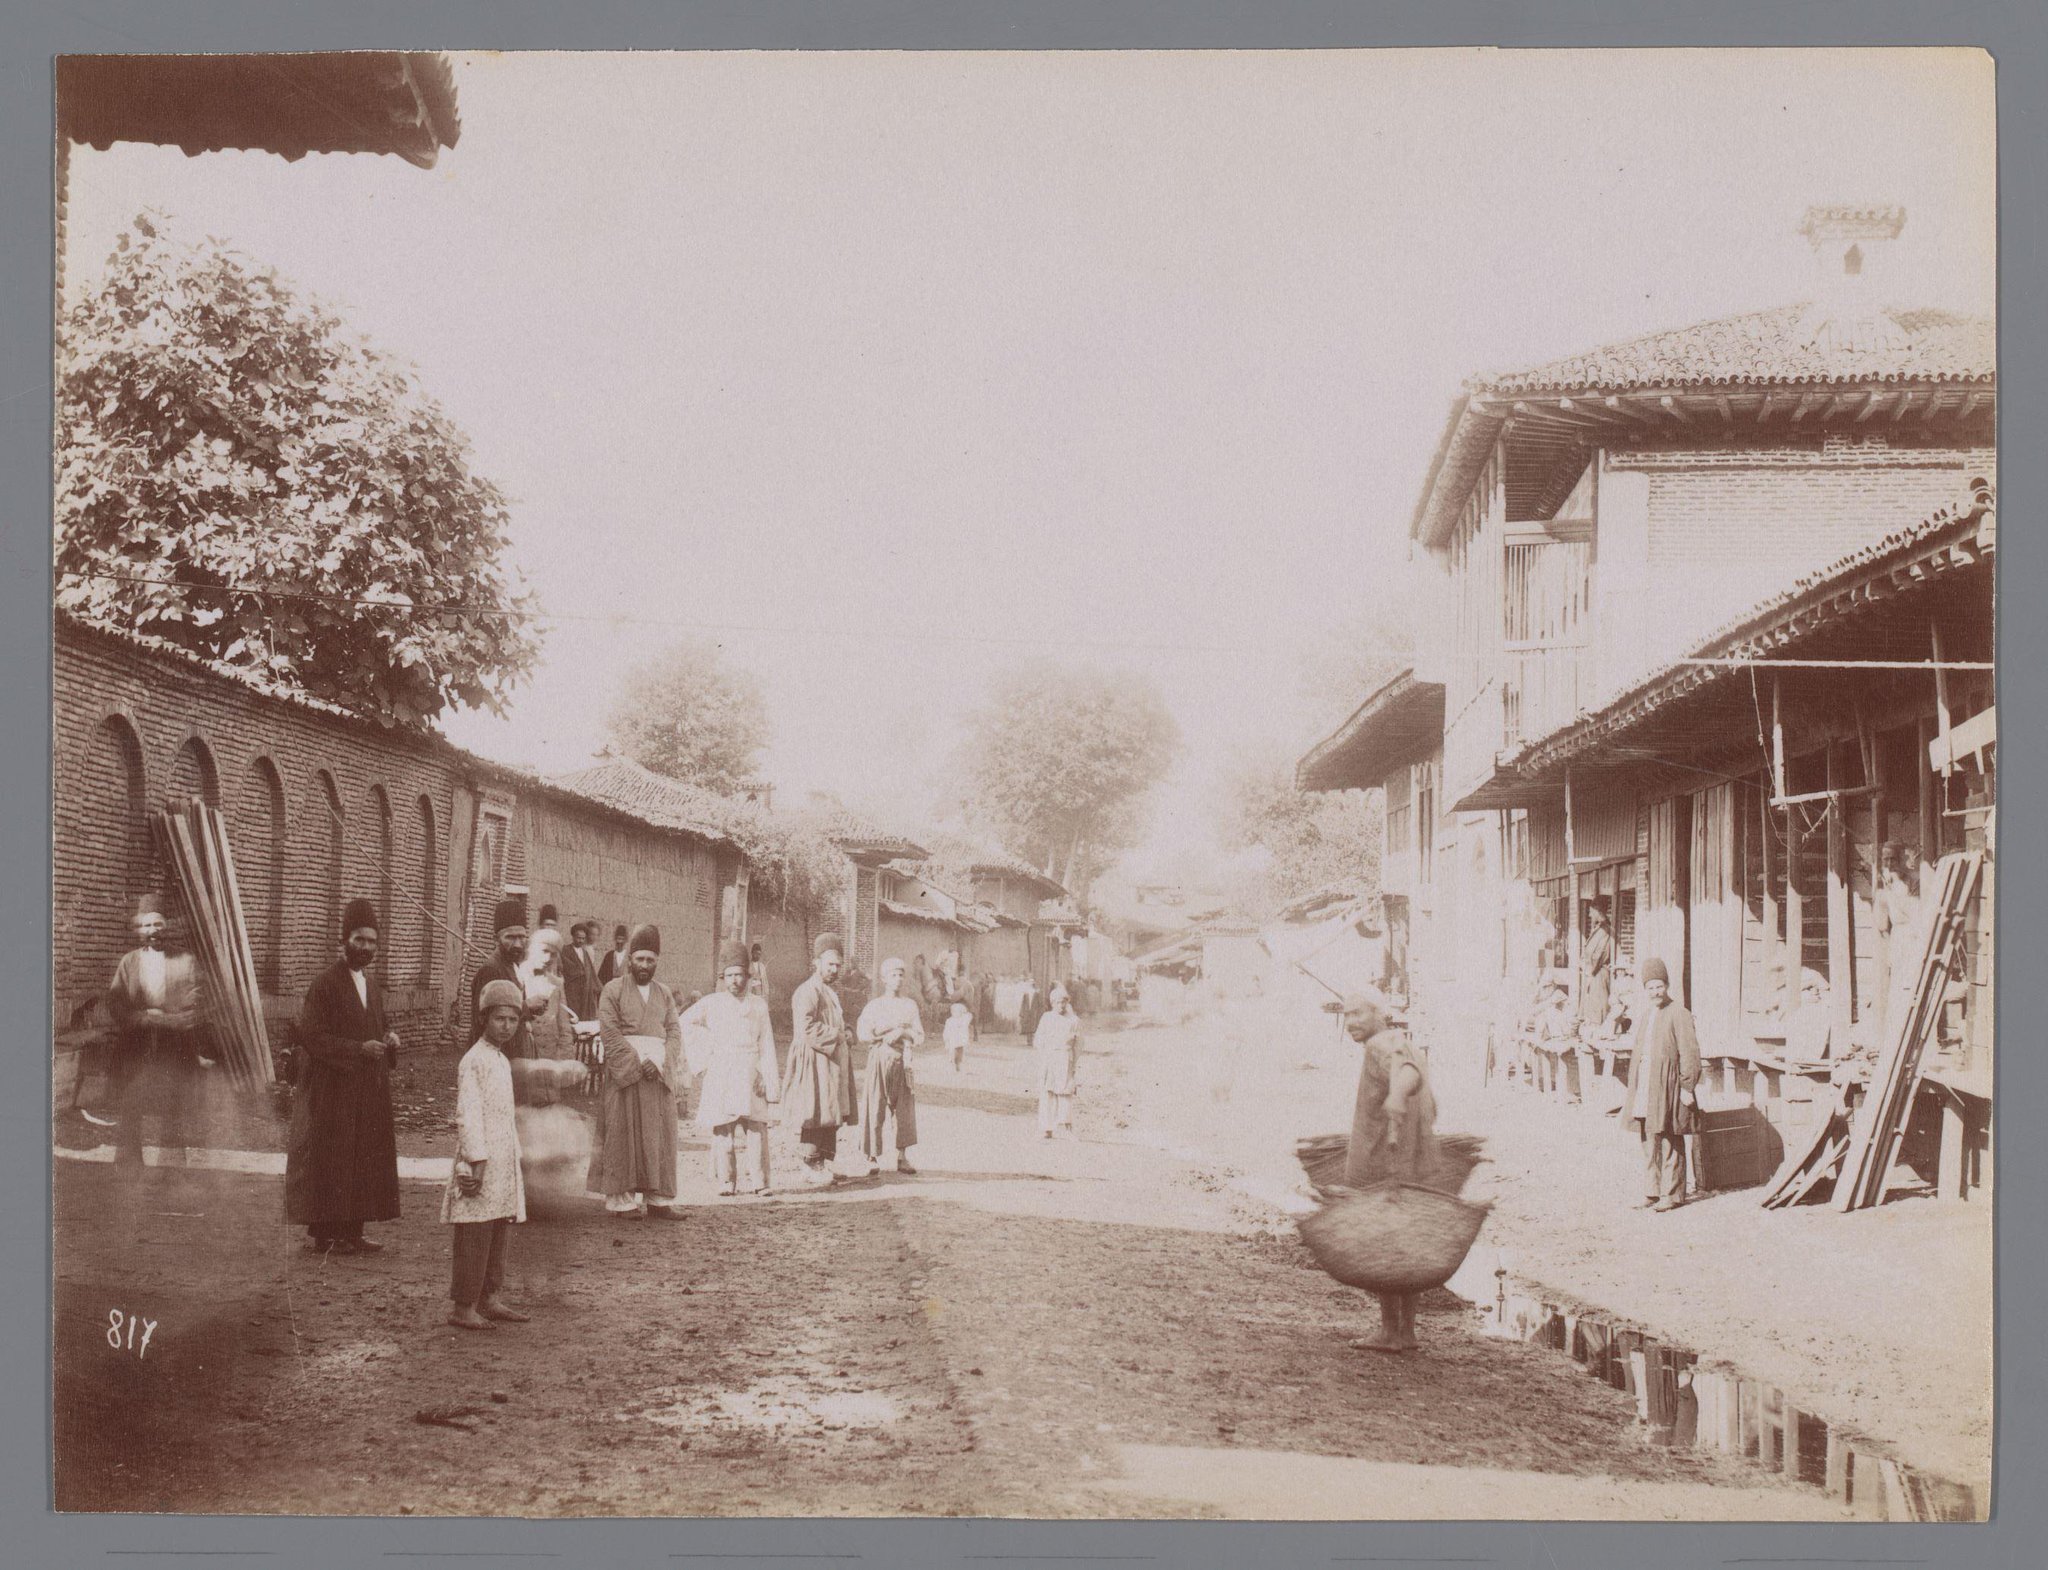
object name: photograph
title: Gezicht op de stad Rescht, Iran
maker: antoine sevruguin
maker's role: fotograaf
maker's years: 1840-1933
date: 1880-1910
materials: paper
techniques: albumen print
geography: iran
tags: iran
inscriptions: number: ‘5.’, inscription: ‘Rescht’, number: ‘817’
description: Gezicht in een straat met winkels en mensen links en rechts van de weg die in de camera kijken. Rescht, Iran.